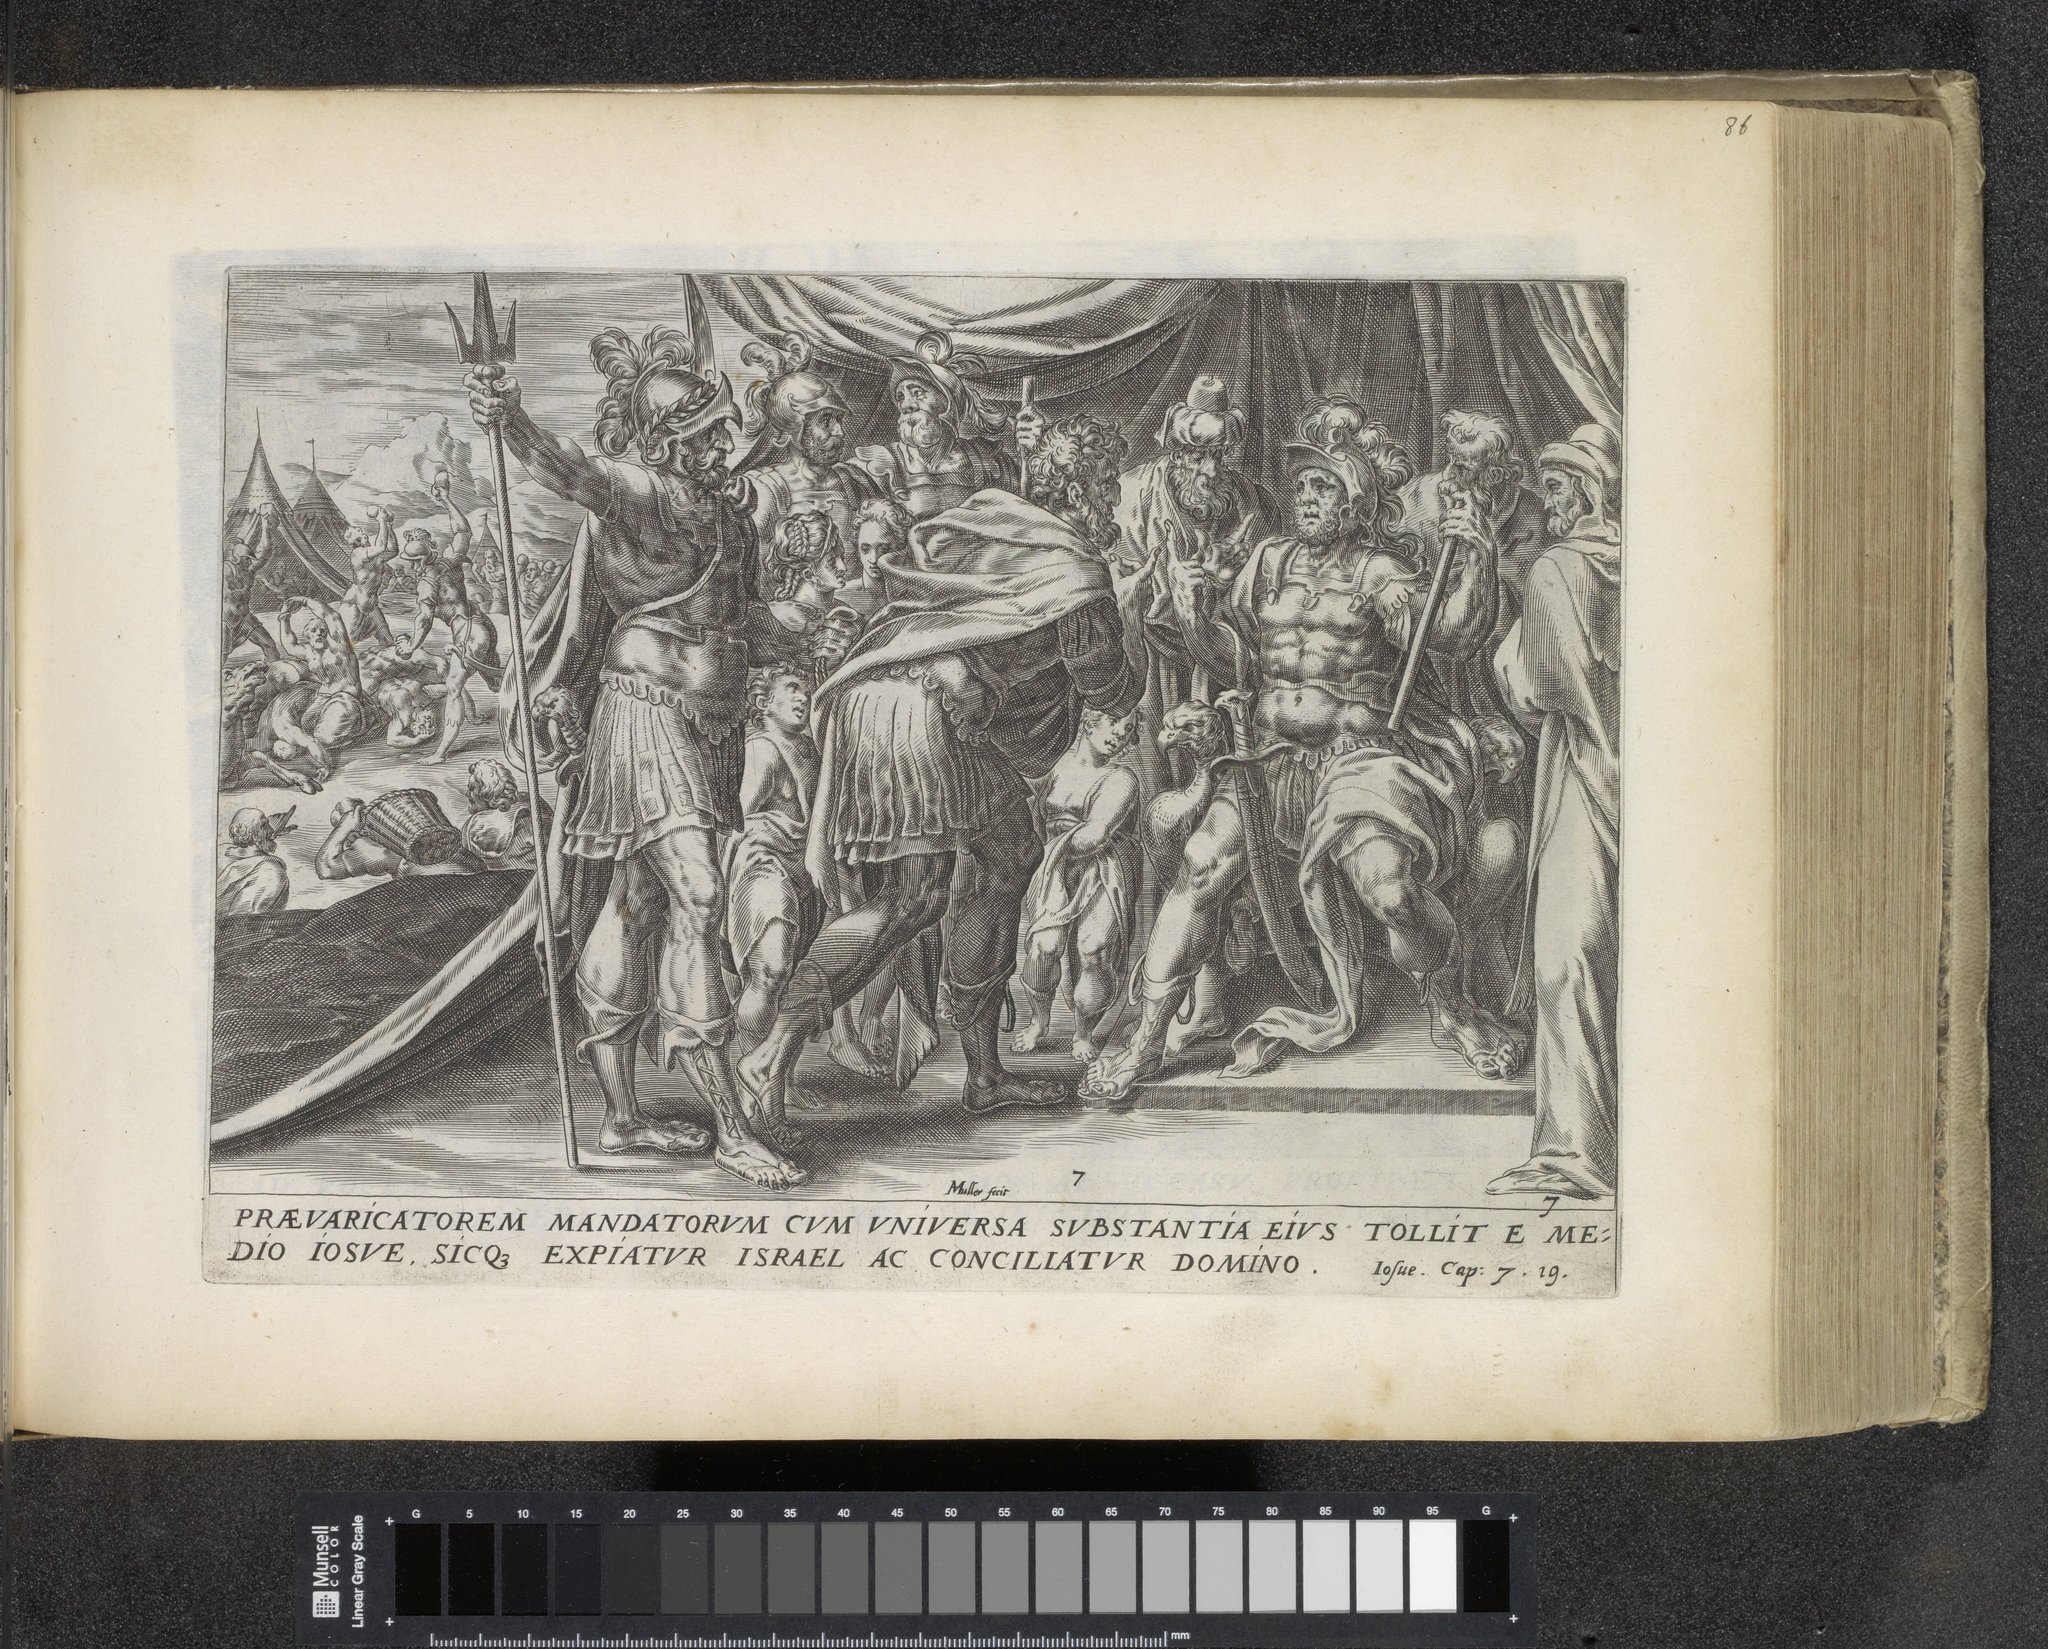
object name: print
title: Achan voor Jozua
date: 1643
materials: paper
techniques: engraving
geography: amsterdam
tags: achan and his family are stoned and burned (aftermath of the fall of jericho), achan confesses to have taken from the spoils a garment and some silver and gold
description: Achan wordt voorgeleid aan Jozua, omdat hij oorlogsbuit had gestolen. Op de achtergrond worden Achan en zijn familie gestenigd. Onder de voorstelling een verwijzing in het Latijn naar de Bijbeltekst in Joz. 7:19. Deze prent maakt deel uit van een album.